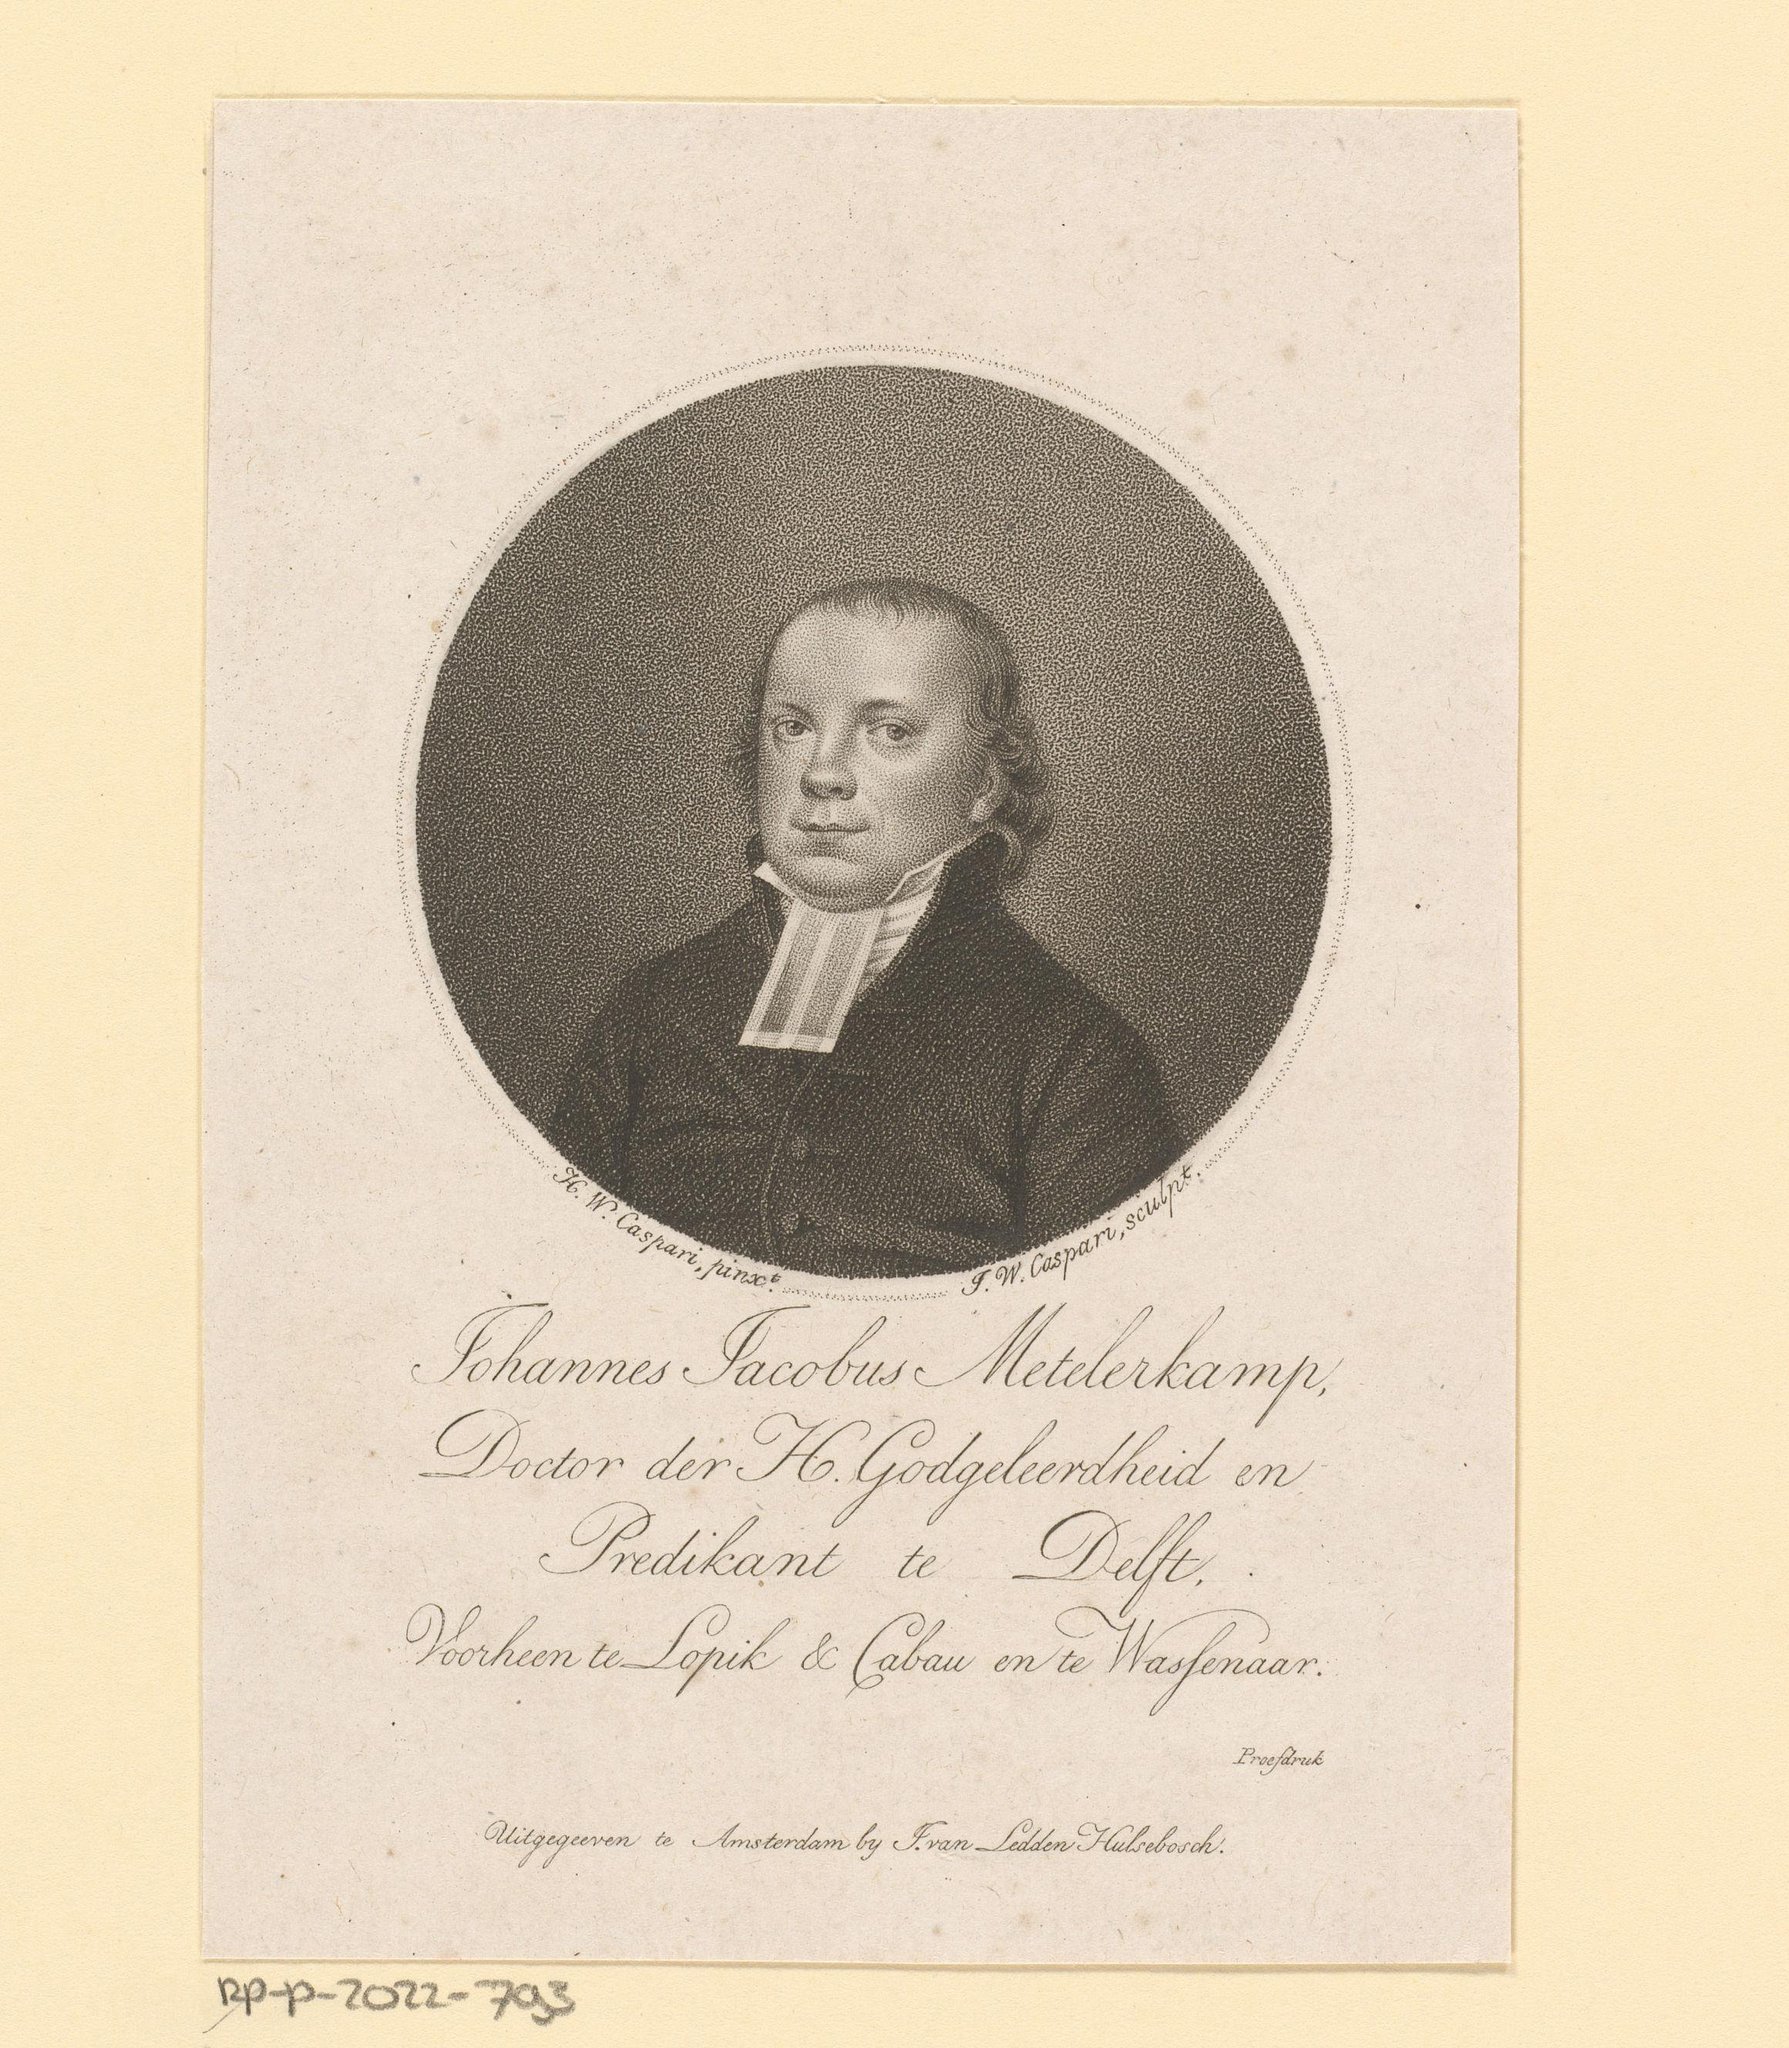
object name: print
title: Johannes Jacobus Metelerkamp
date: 1803-1819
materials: paper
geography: amsterdam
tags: gouda, utrecht, historical persons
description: Met drieregelig onderschrift in het Nederlands.